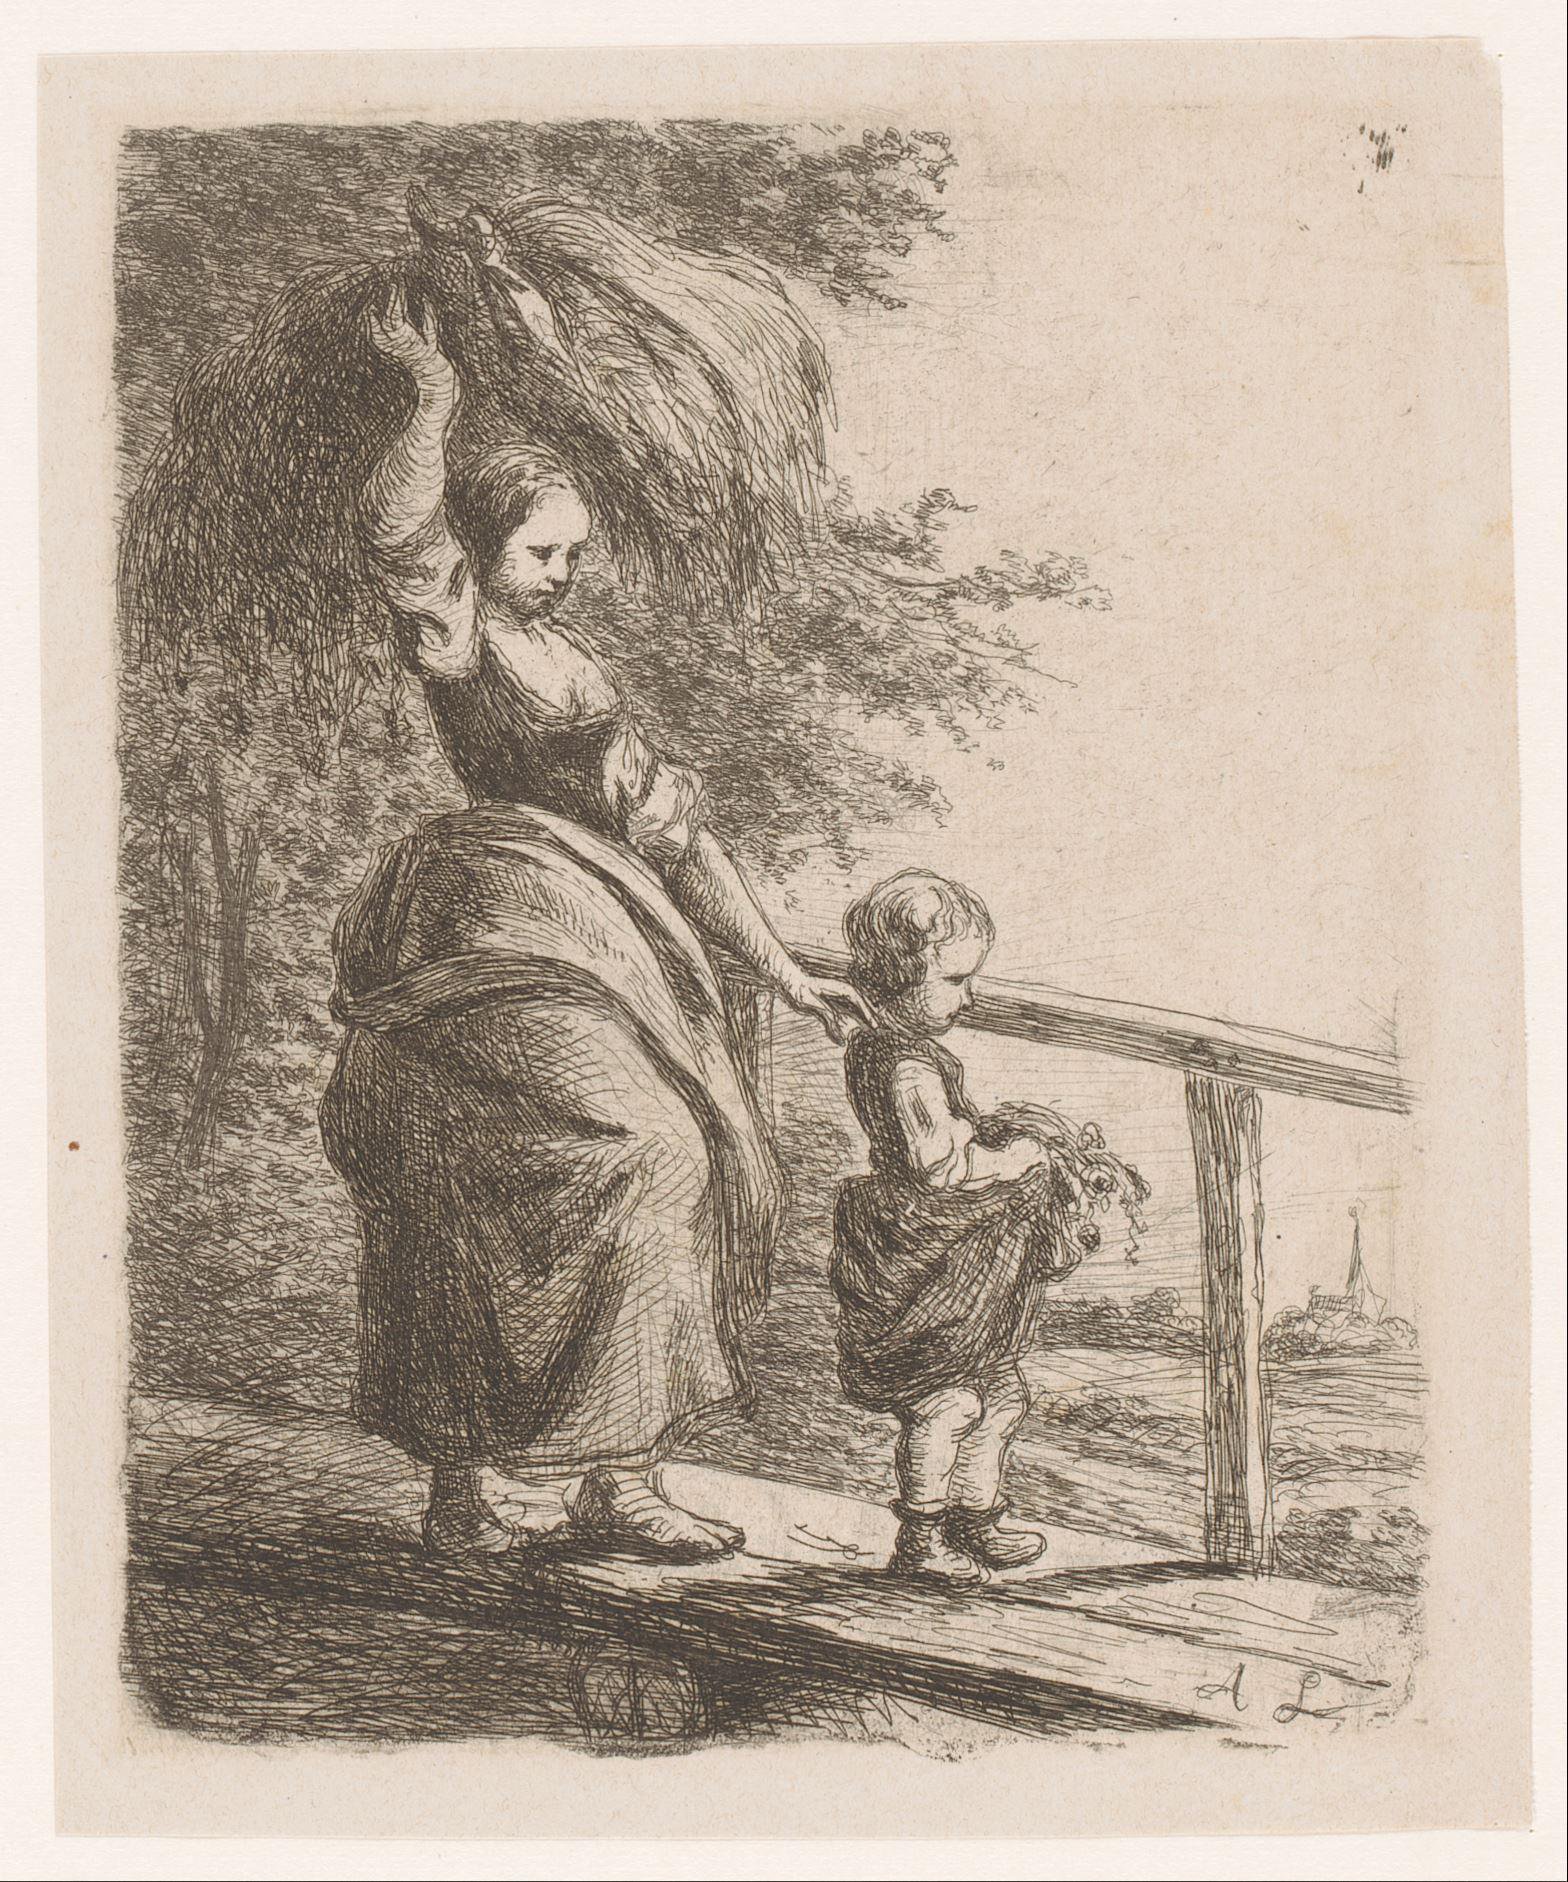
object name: print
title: Vrouw draagt hooi op het hoofd en leidt een kind over een houten brug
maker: alexandre louis lion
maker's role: print maker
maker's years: 1823-1852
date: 1833-1852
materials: paper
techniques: drypoint, etching, intaglio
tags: mother and child(ren), woman and child(ren) (family group)